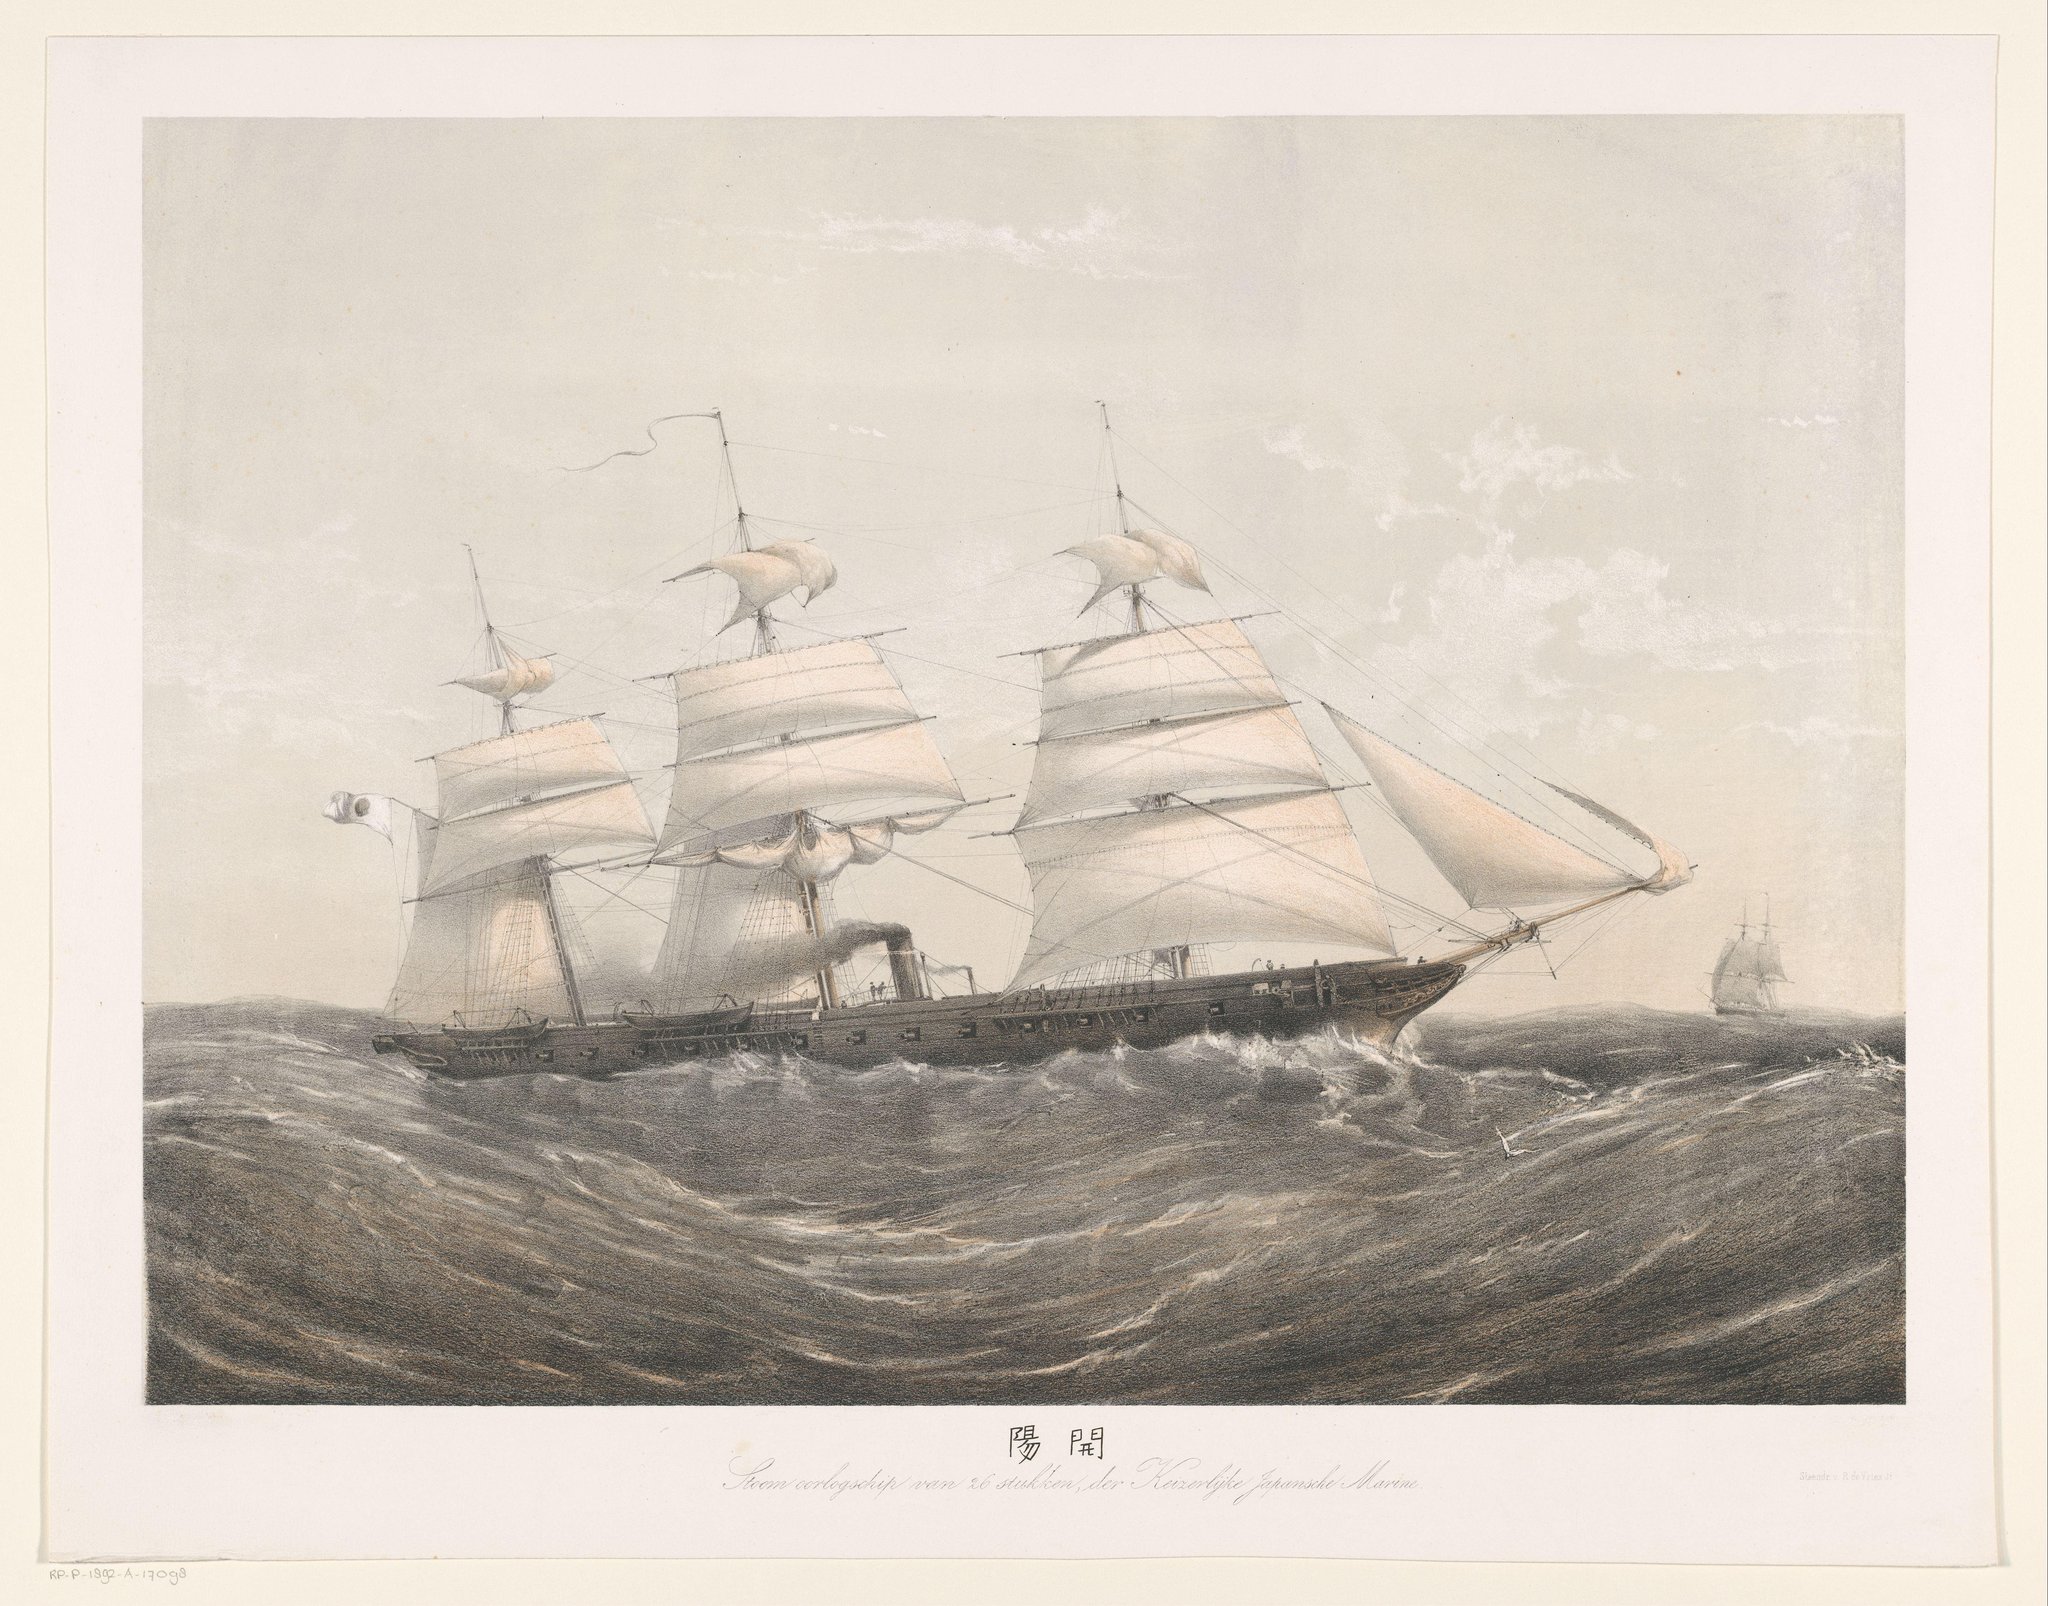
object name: print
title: Japans stoomoorlogsschip varend op zee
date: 1847-1874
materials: paper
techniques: tone lithography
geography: amsterdam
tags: ships (in general)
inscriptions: collector's mark: Lugt 2228